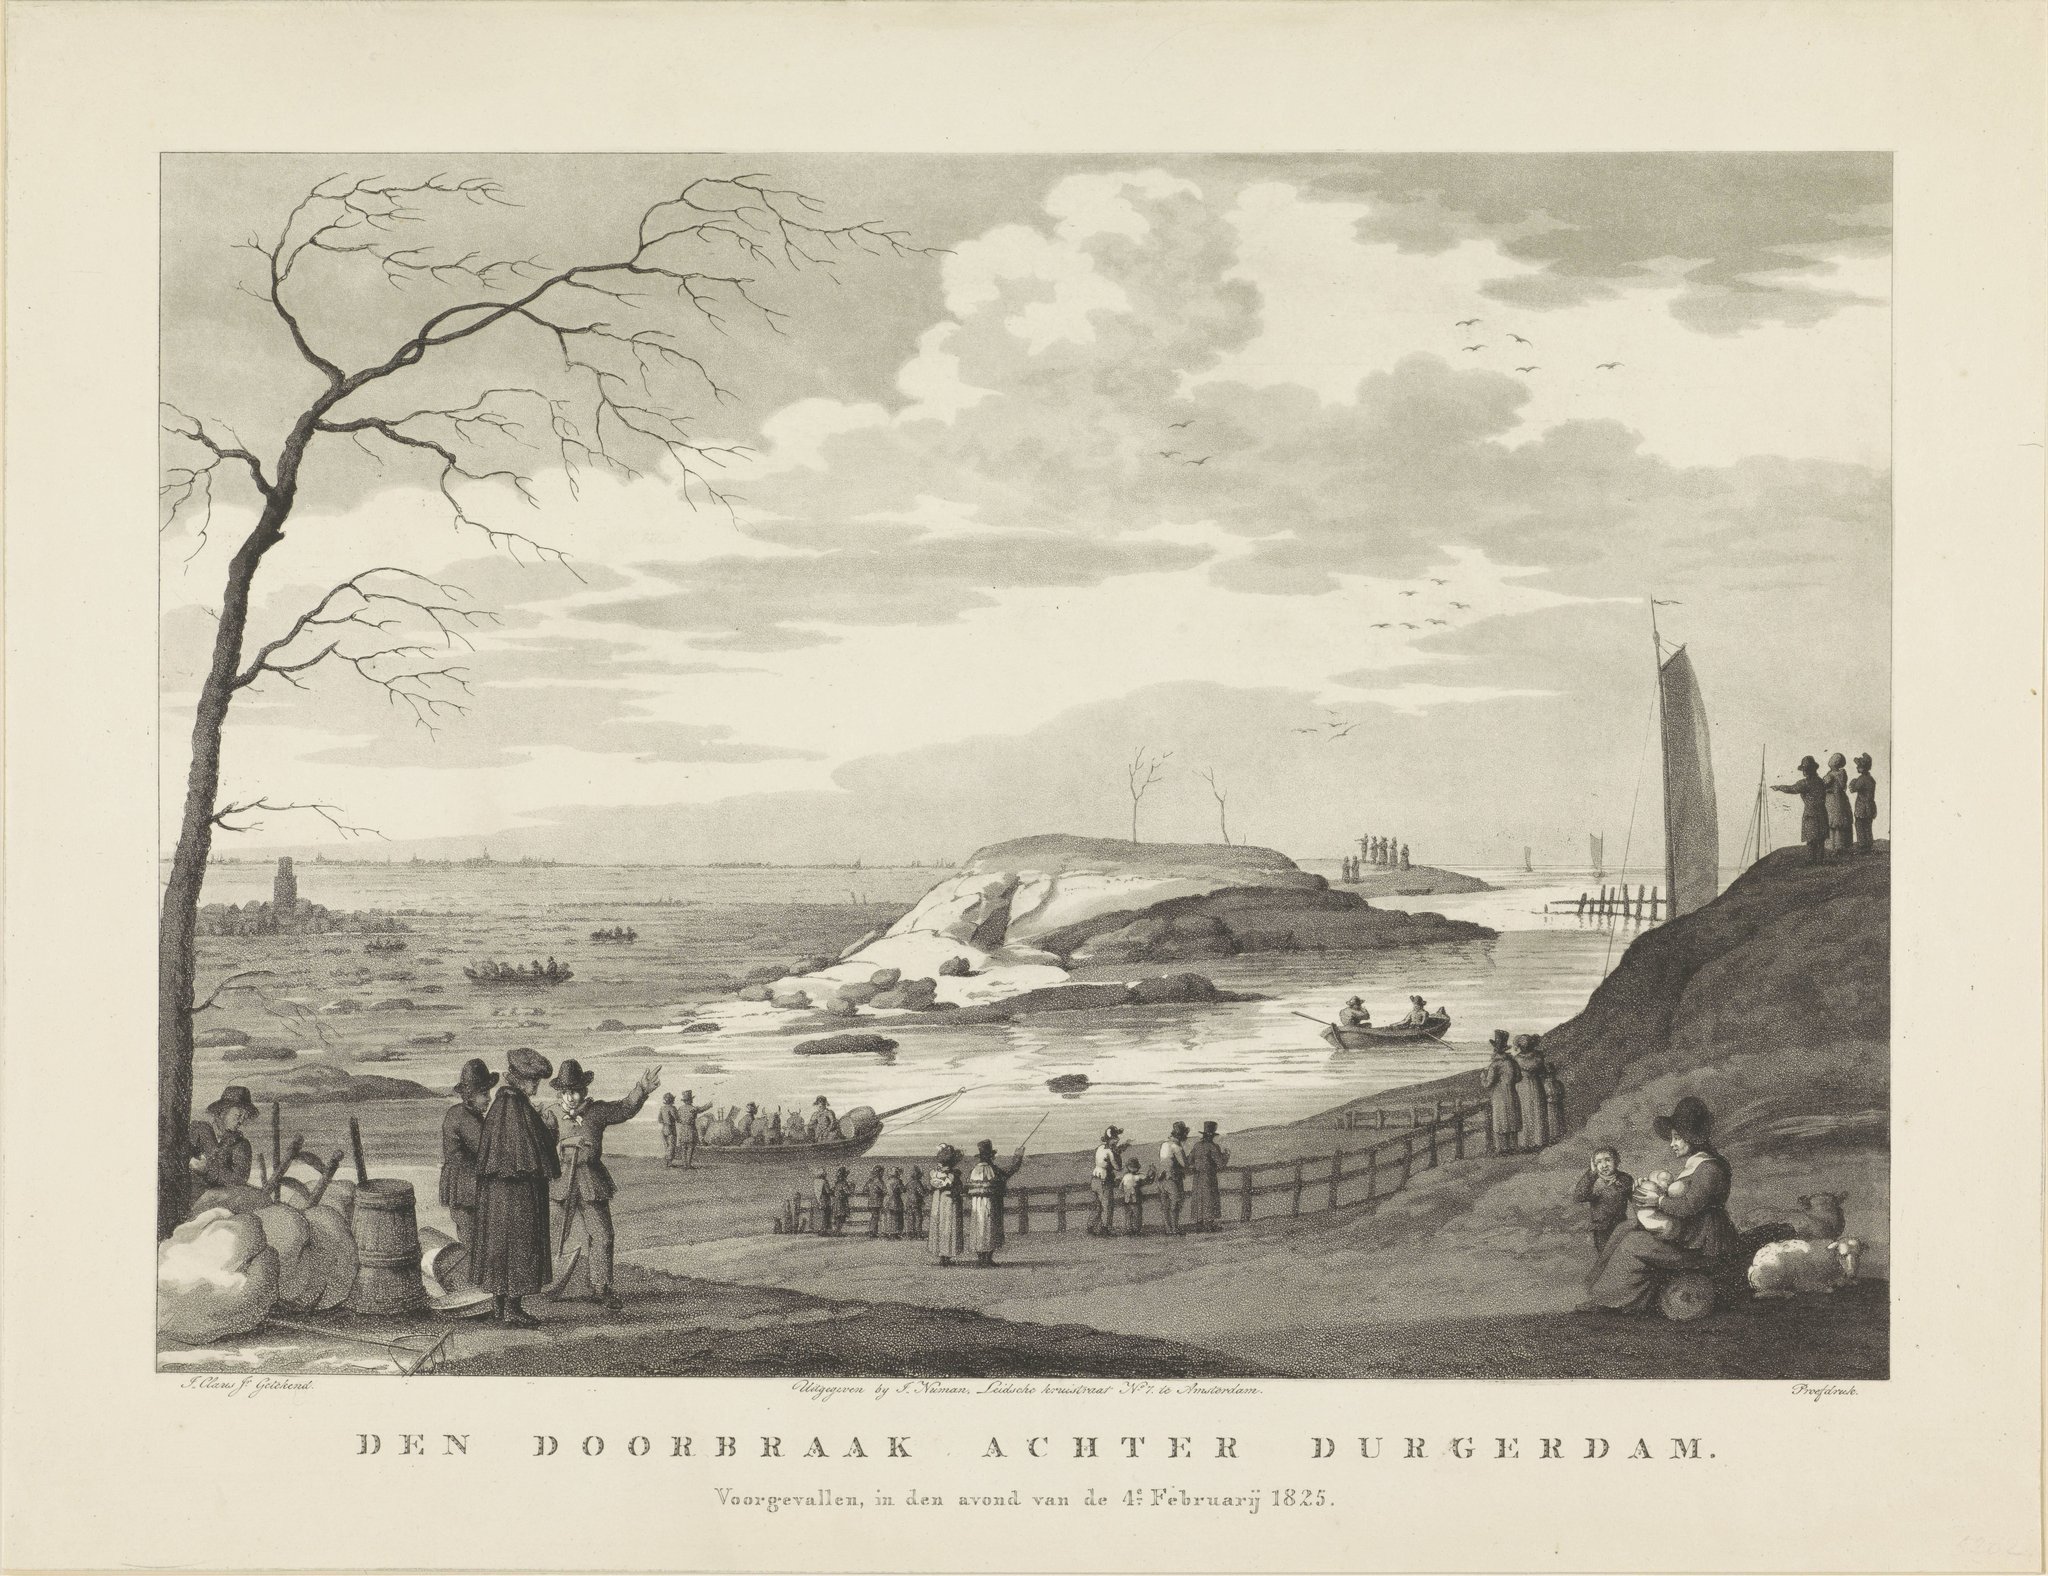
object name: print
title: Den doorbraak achter Durgerdam. Voorgevallen, in den avond van de 4e Februarij 1825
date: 1825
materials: paper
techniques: aquatint, etching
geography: amsterdam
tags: dike-break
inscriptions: collector's mark: Lugt 2228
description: Gezicht over het ondergelopen land als gevolg van de dijkdoorbraak bij Durgerdam, 4 februari 1825. Rechts geeft een zittende vrouw haar kind de borst, in het midden en links meerdere groepjes mensen. Zie ook de pendant.